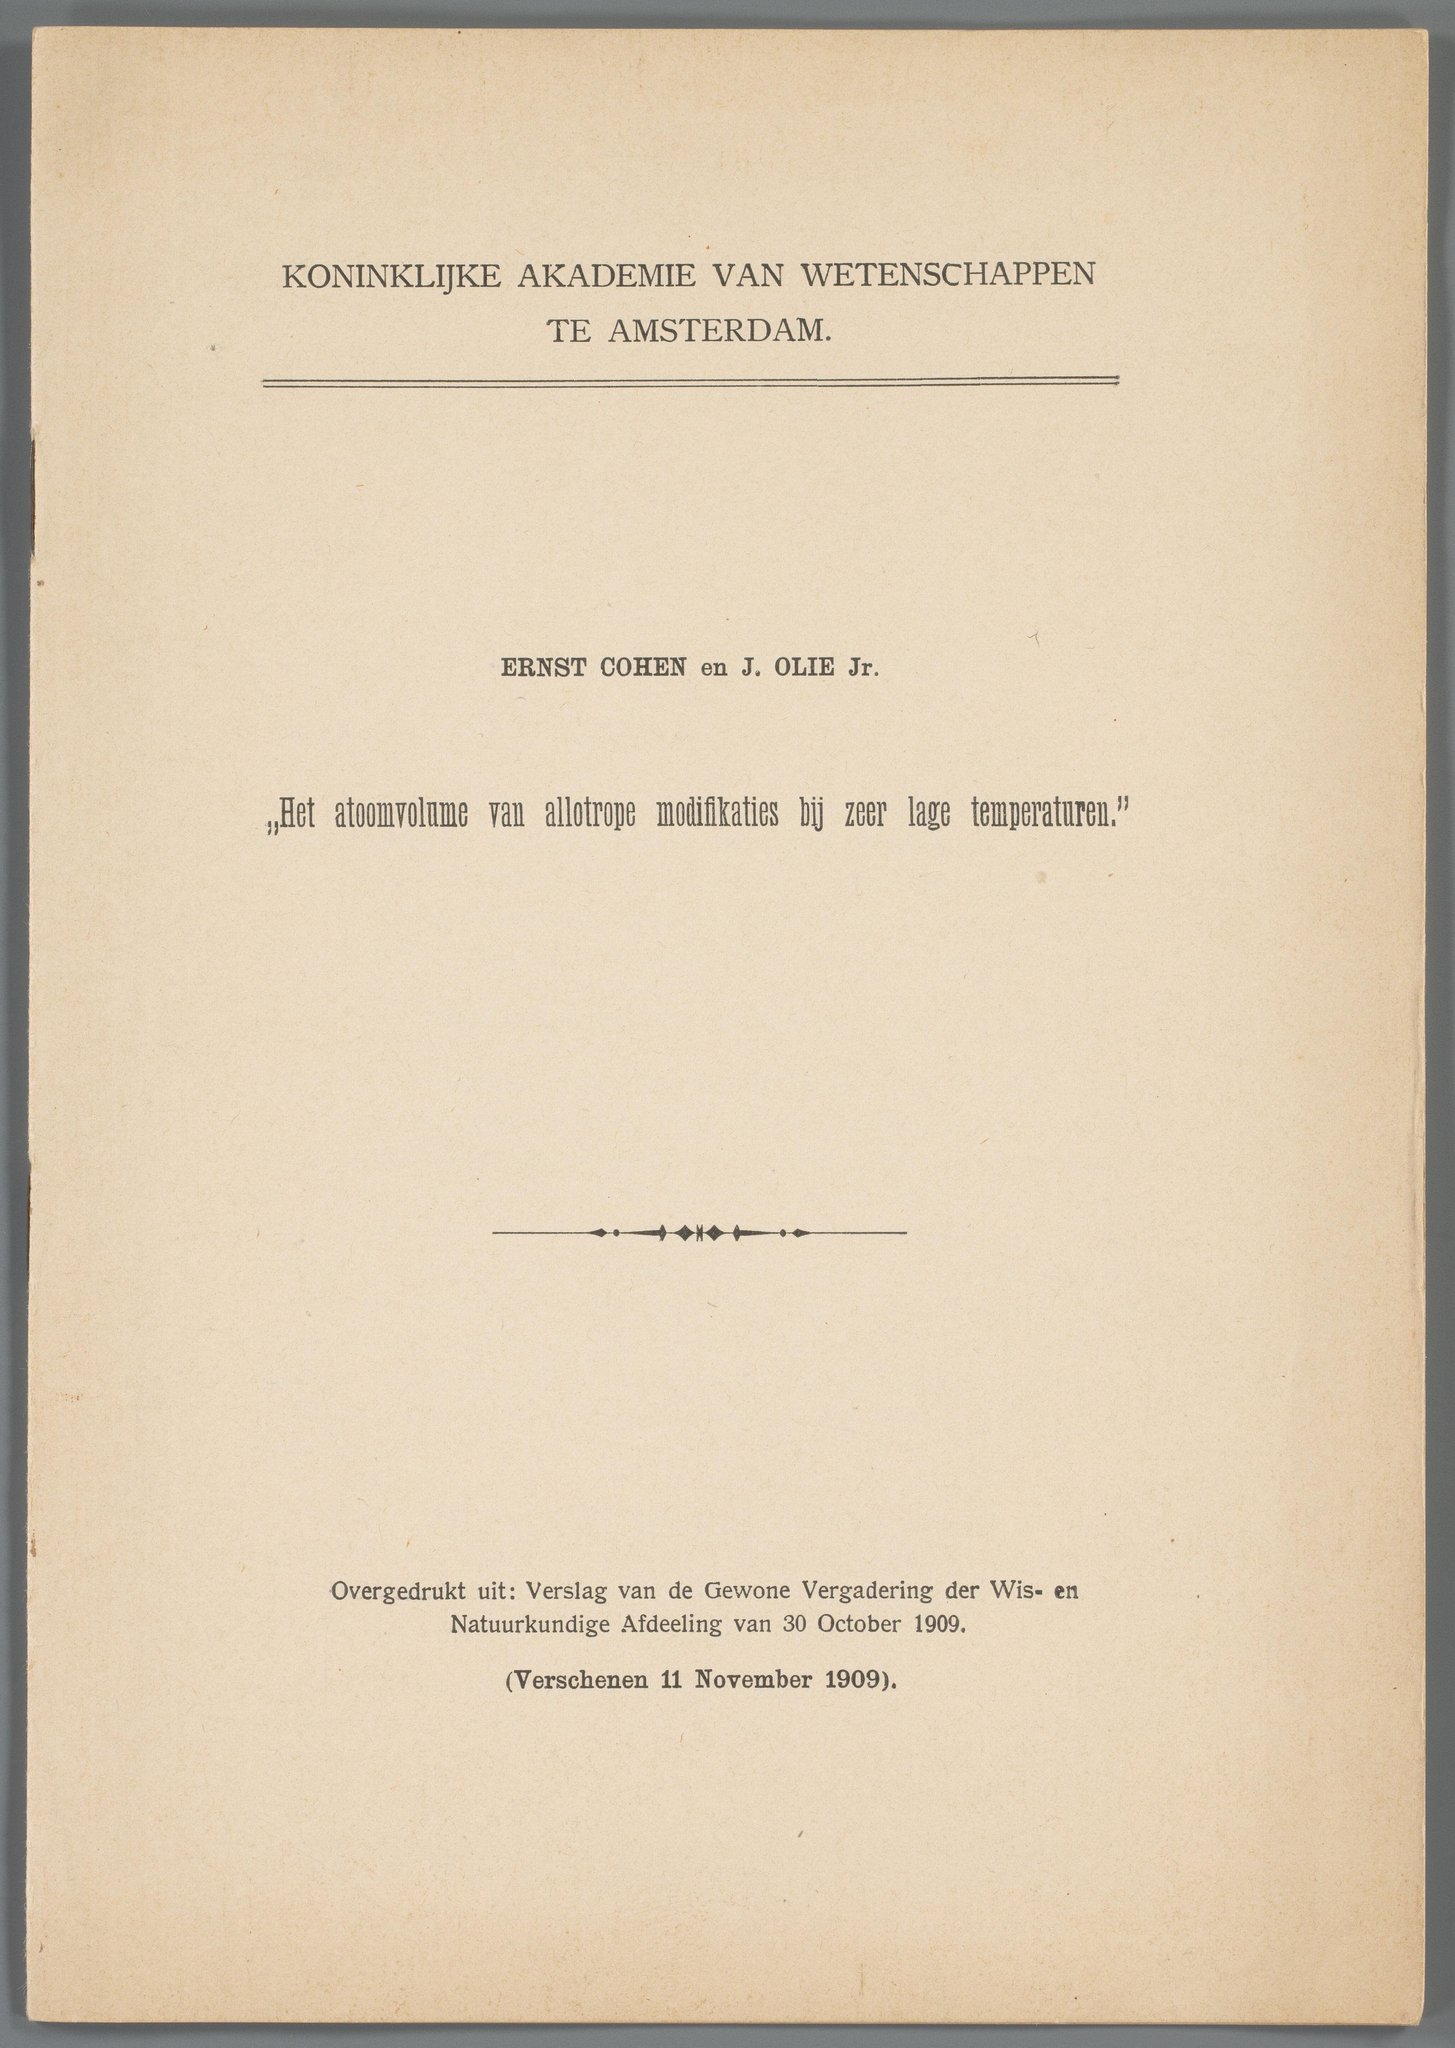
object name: offprint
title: Het atoomvolume van allotrope modifikaties bij zeer lage temperaturen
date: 1909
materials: paper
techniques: letterpress printing, printing block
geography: utrecht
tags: printed matter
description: Overdruk uit het verslag van de 'Gewone Vergadering der Wis- en Natuurkundige Afdeeling' op 30 oktober 1909.